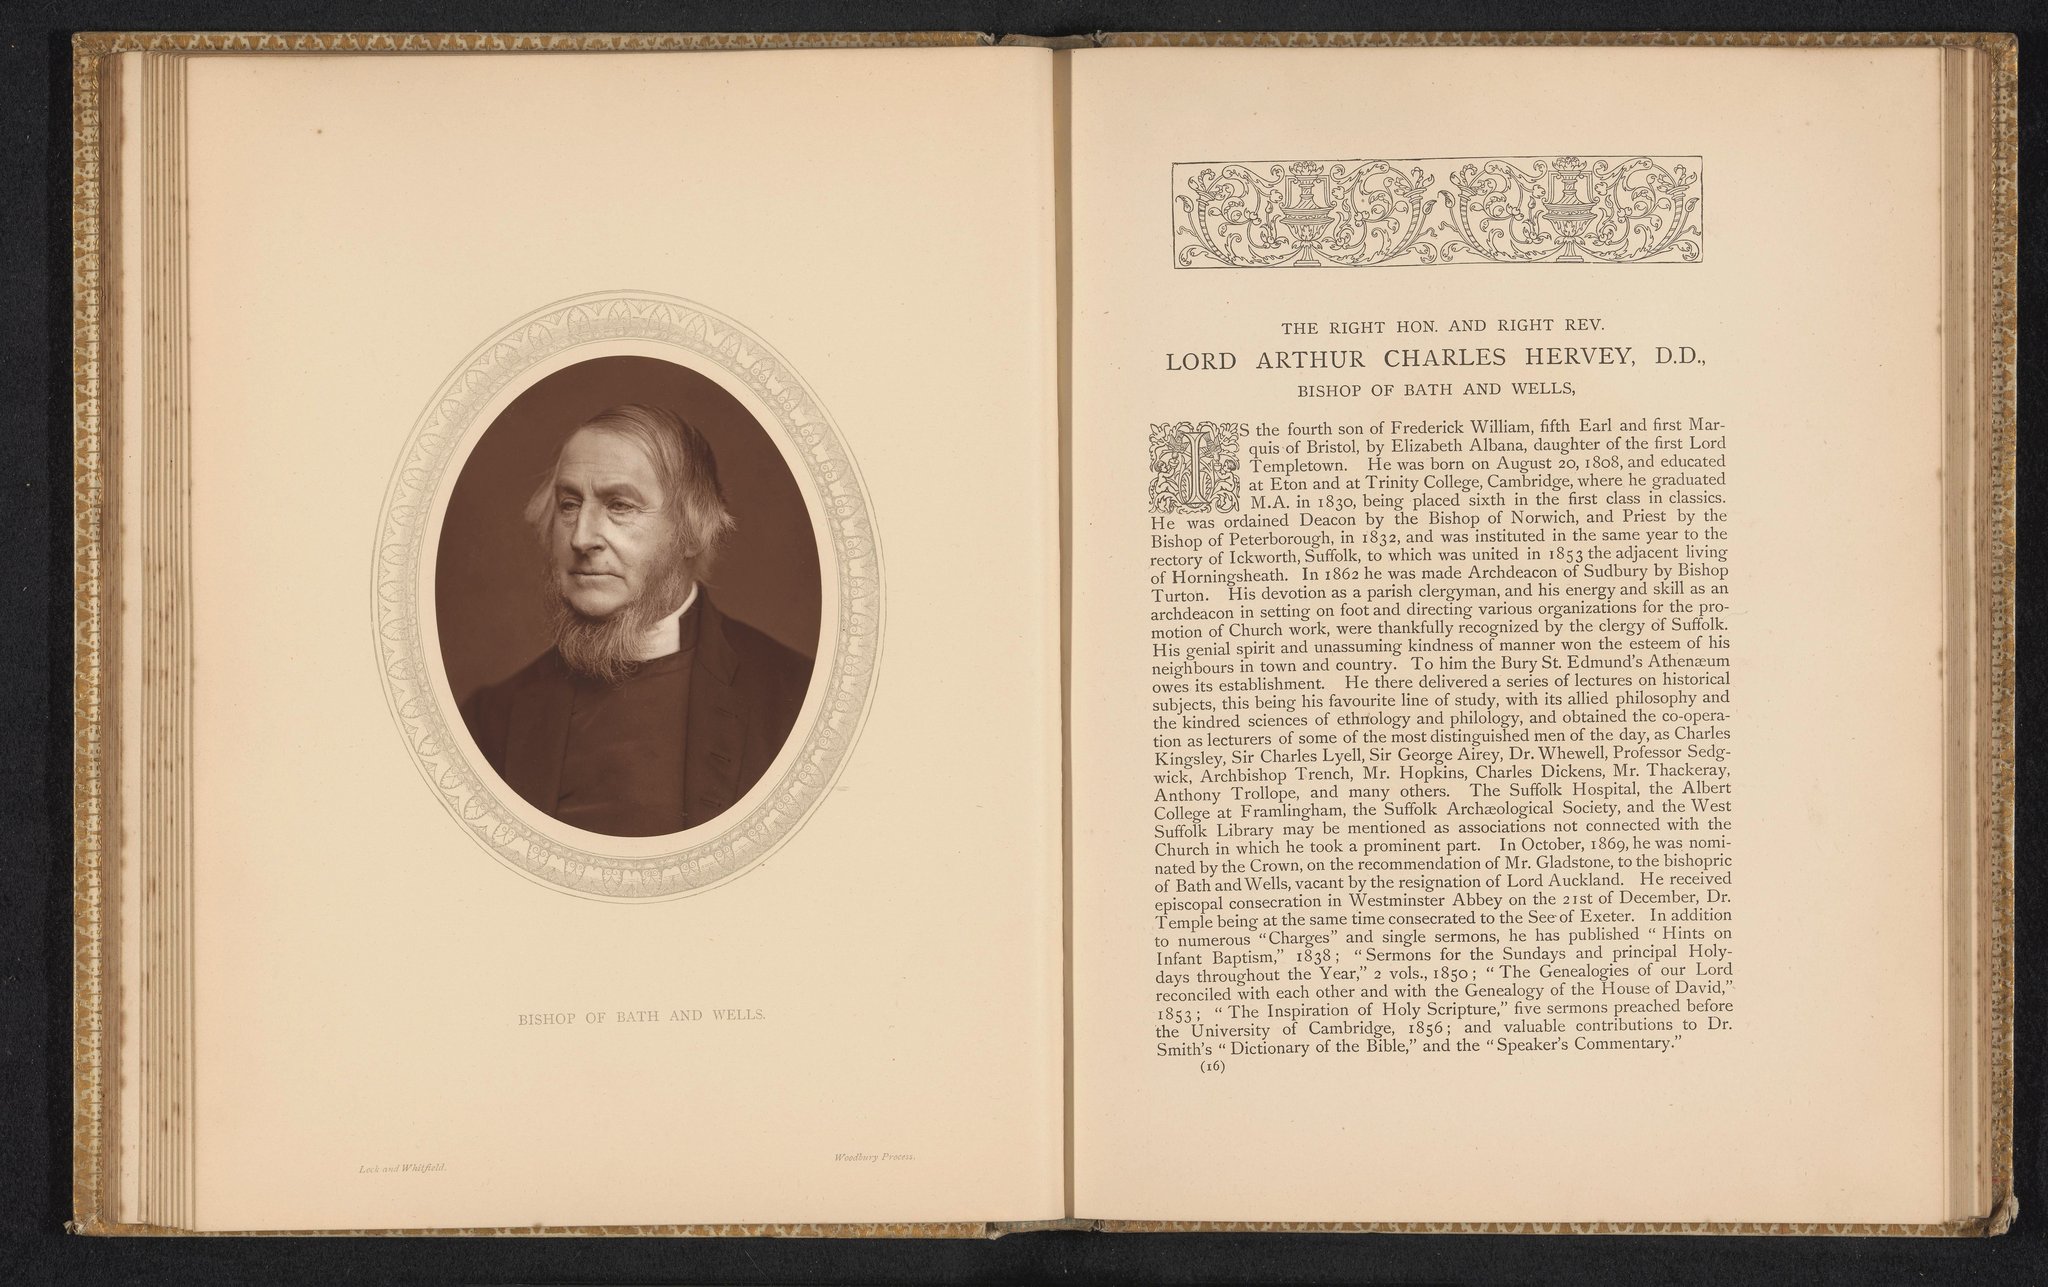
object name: photomechanical print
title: Bishop of Bath and Wells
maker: Anonymous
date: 1875-1880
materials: paper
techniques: woodburytype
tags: archbishop, bishop, etc. (roman catholic), historical persons (portraits and scenes from the life) (+ (full) bust portrait)